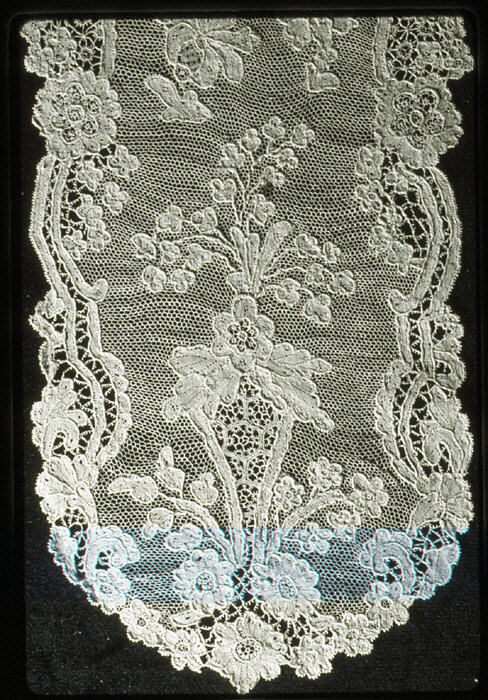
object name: lappet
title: Joined lappets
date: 1751-1775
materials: linen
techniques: lace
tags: flowers